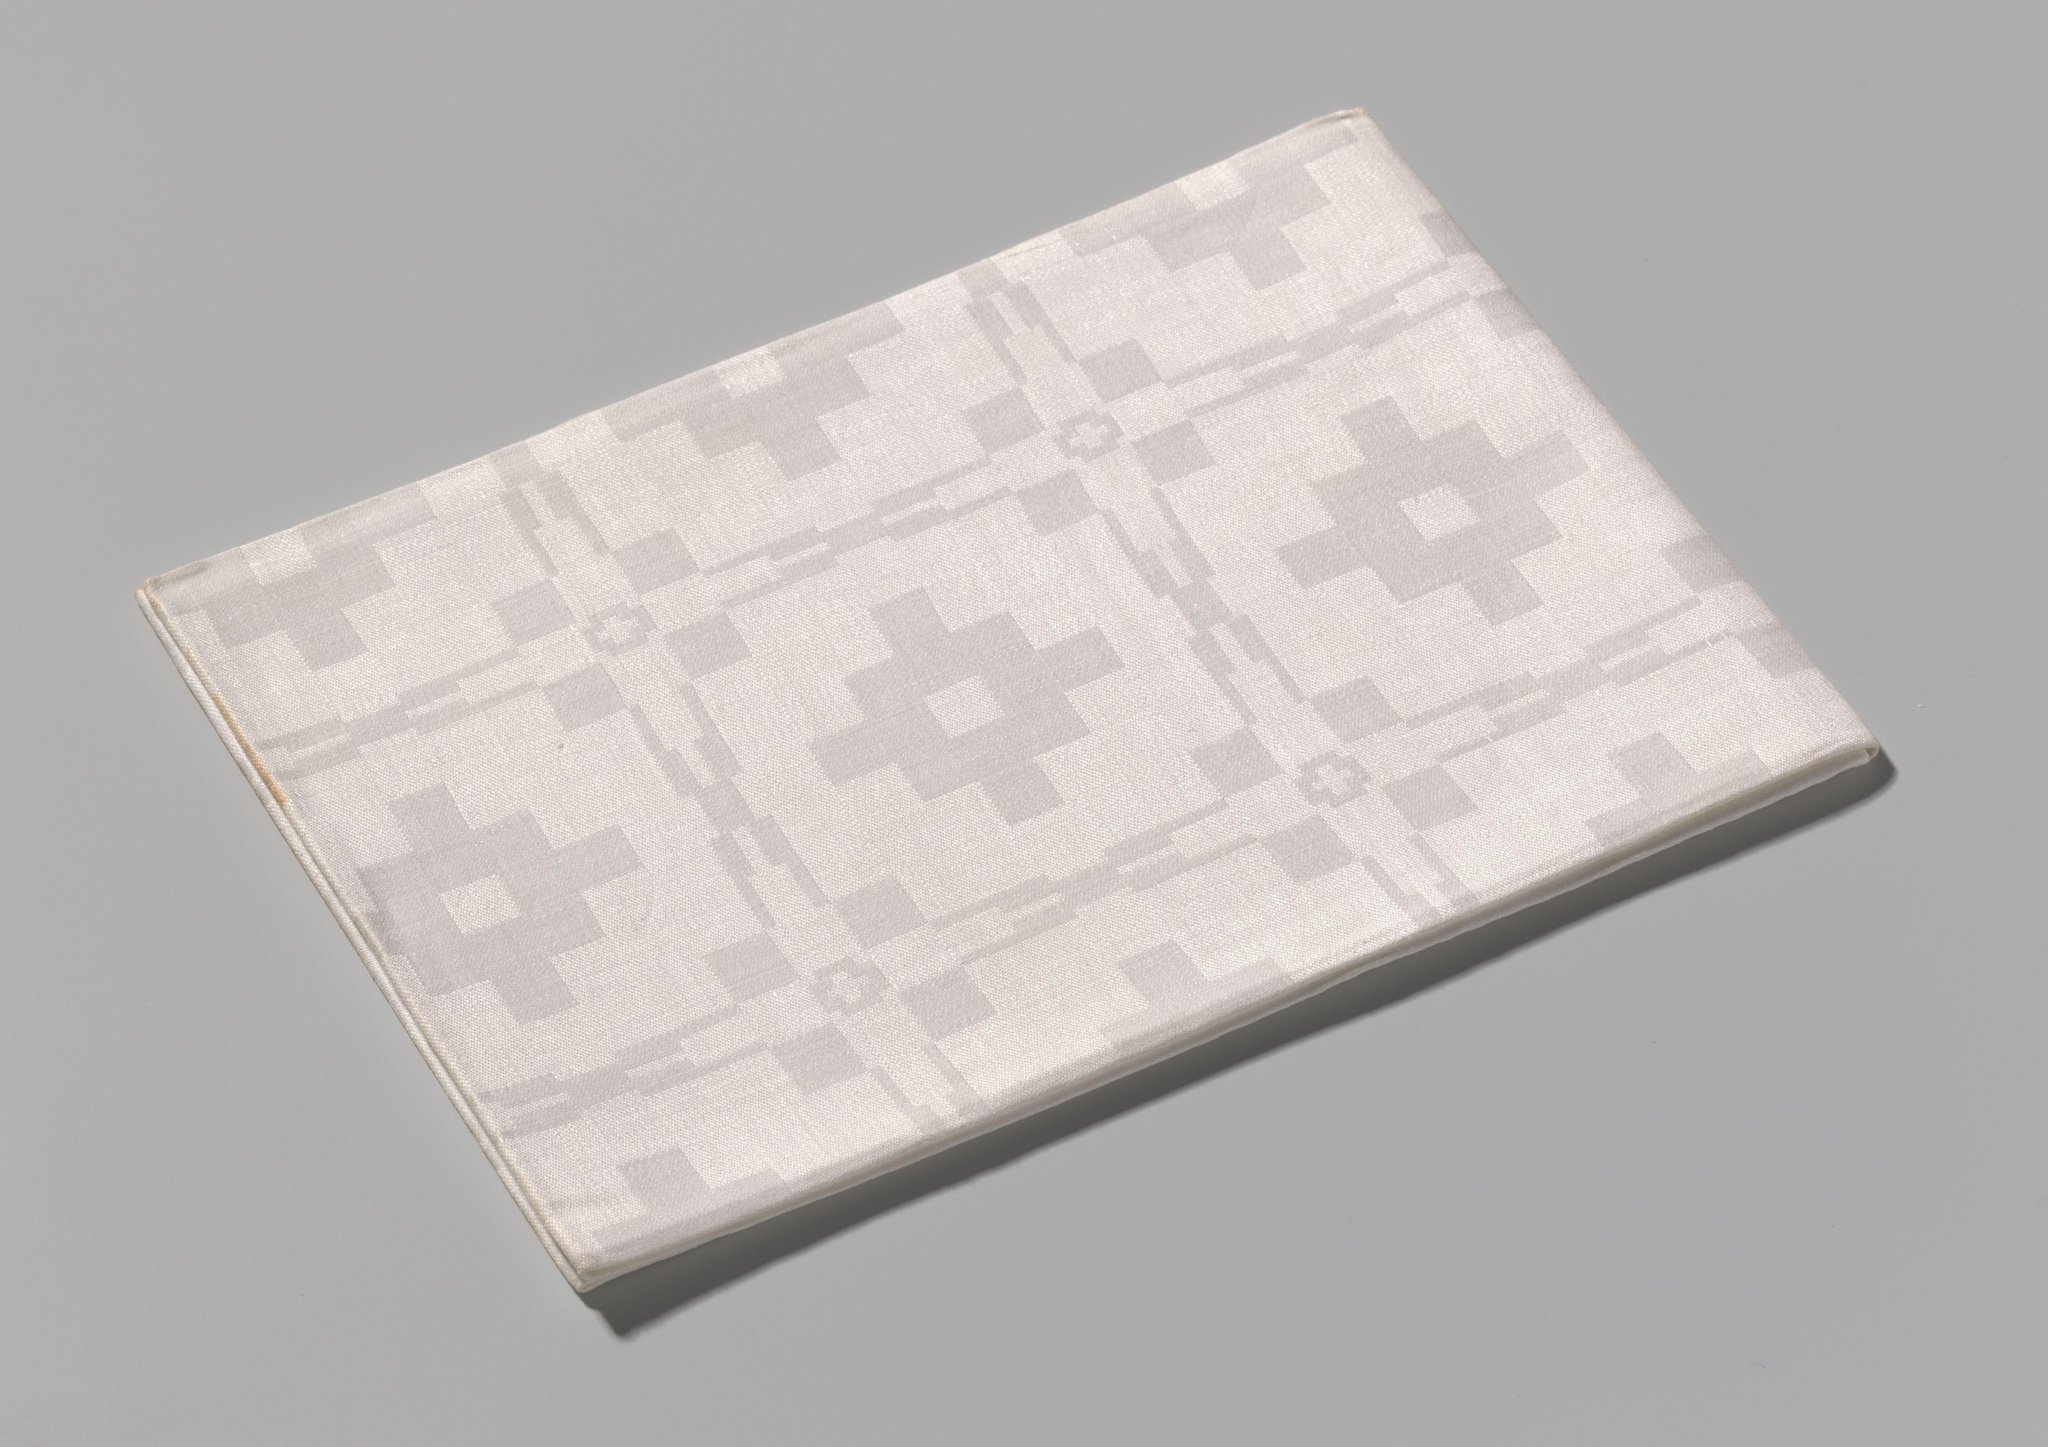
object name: napkin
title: Servet van linnen met pellenpatroon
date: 1800-1899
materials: linen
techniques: peeled fabric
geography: netherlands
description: wit linnen servet met pellen patroon 'uitgehouwen steen of hoekster' en randen WH 2oonl